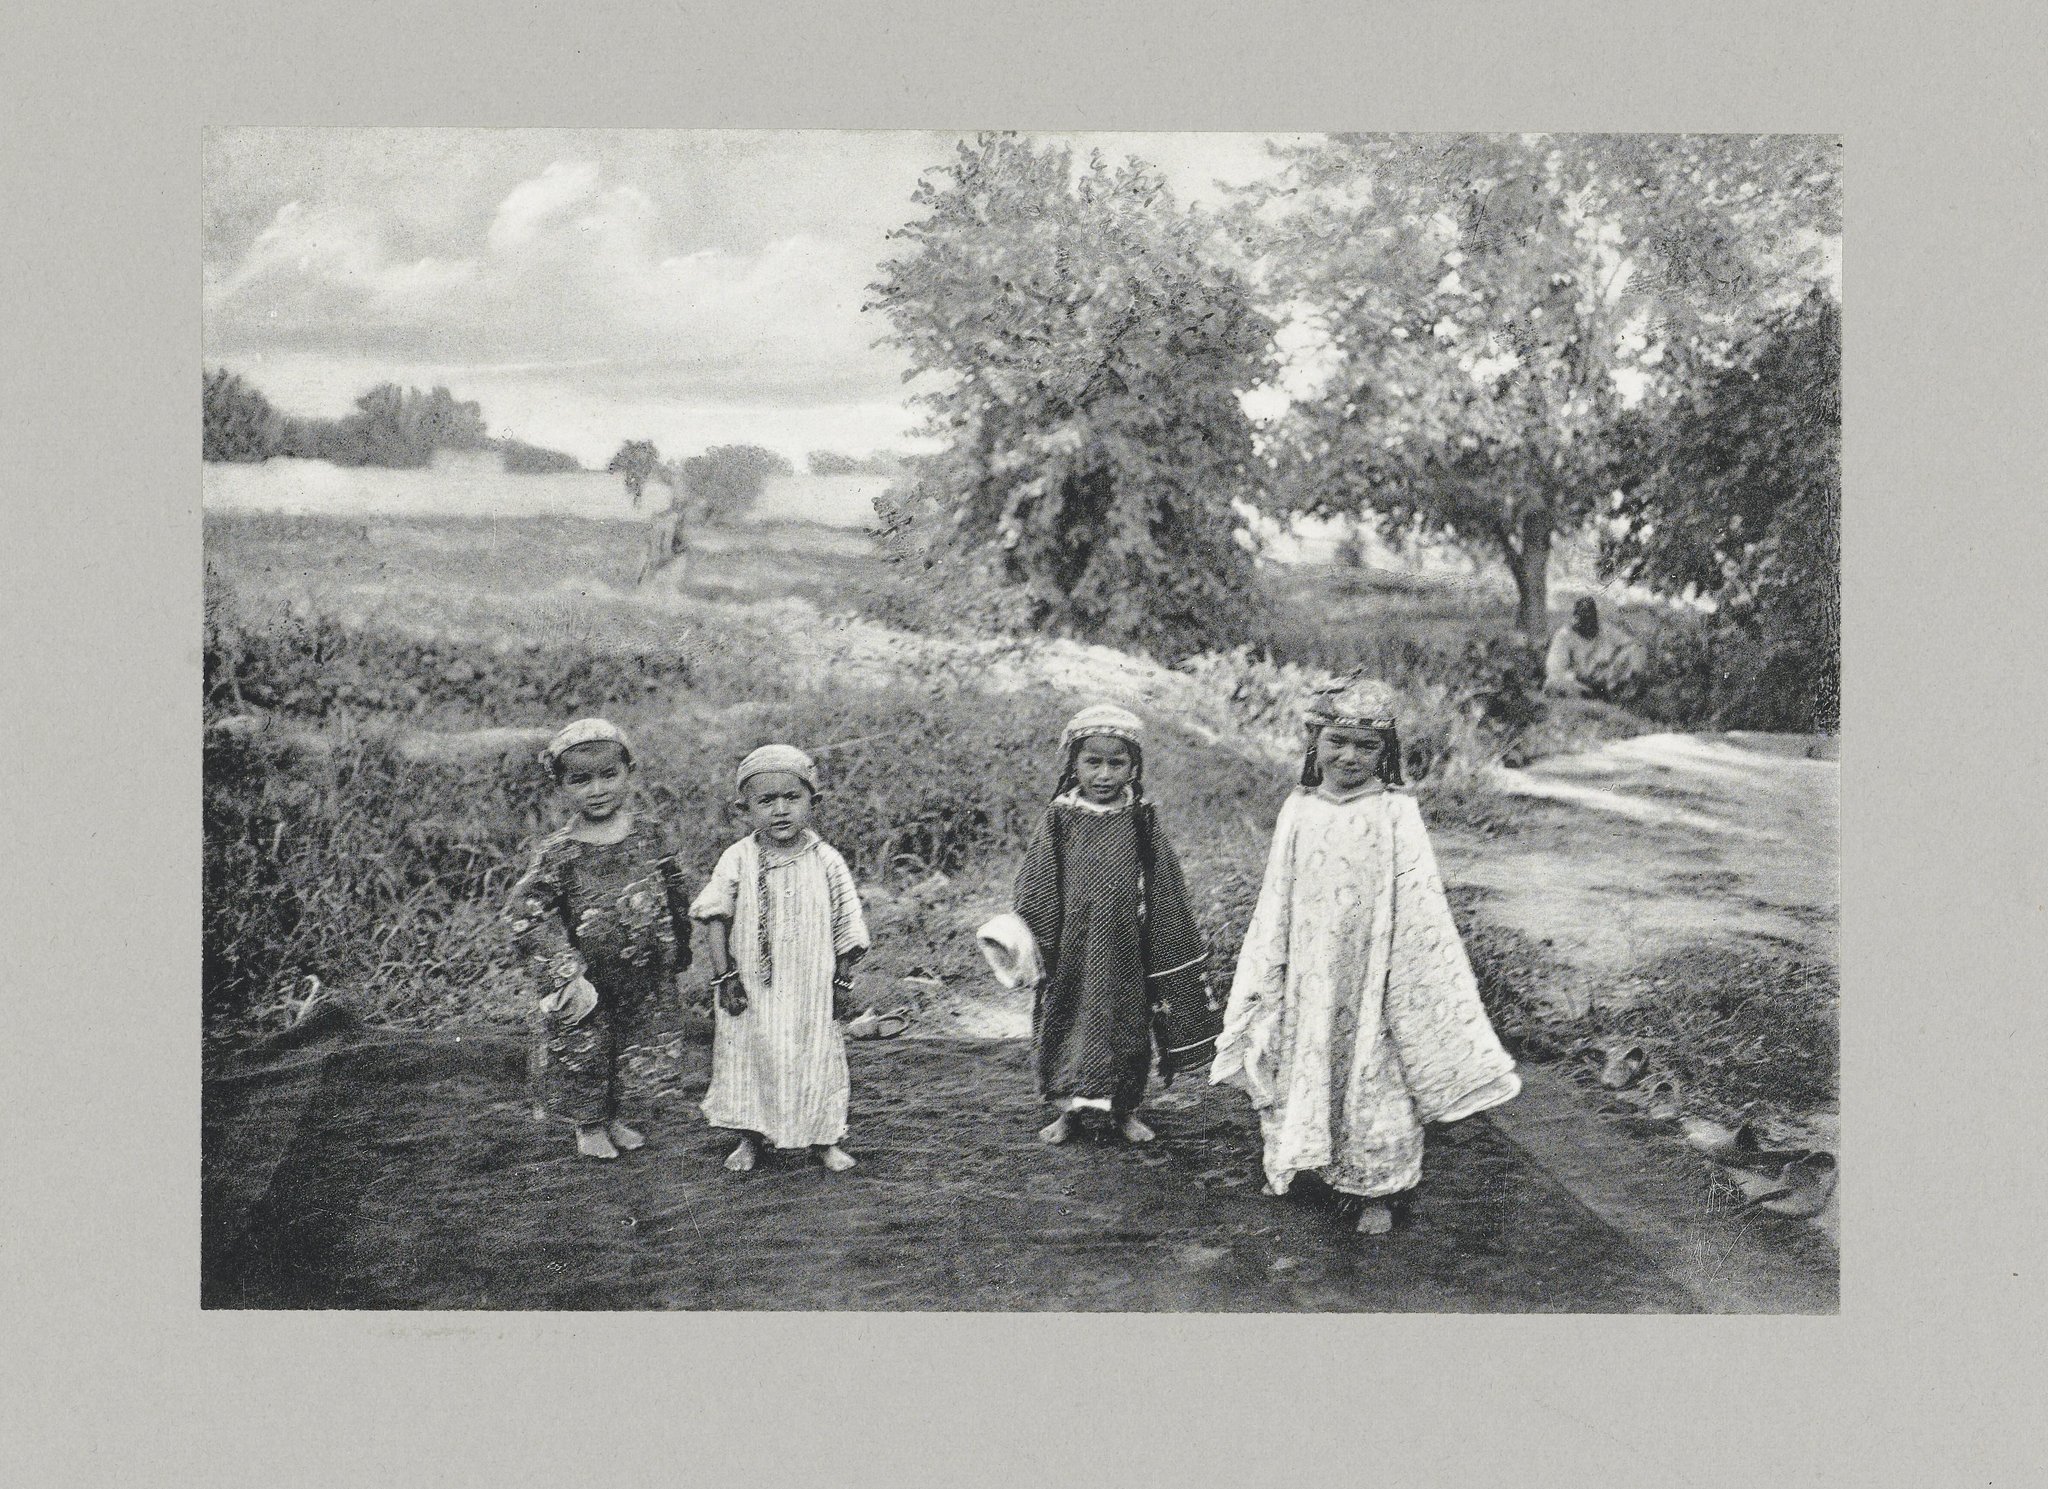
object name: photomechanical print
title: Vier Turkestaanse kinderen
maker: Anonymous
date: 1895-1915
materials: cardboard, paper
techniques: photograph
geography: turkestan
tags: turkestan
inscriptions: number: ‘28.’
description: Vier kinderen staand op een kleed in een landschap.